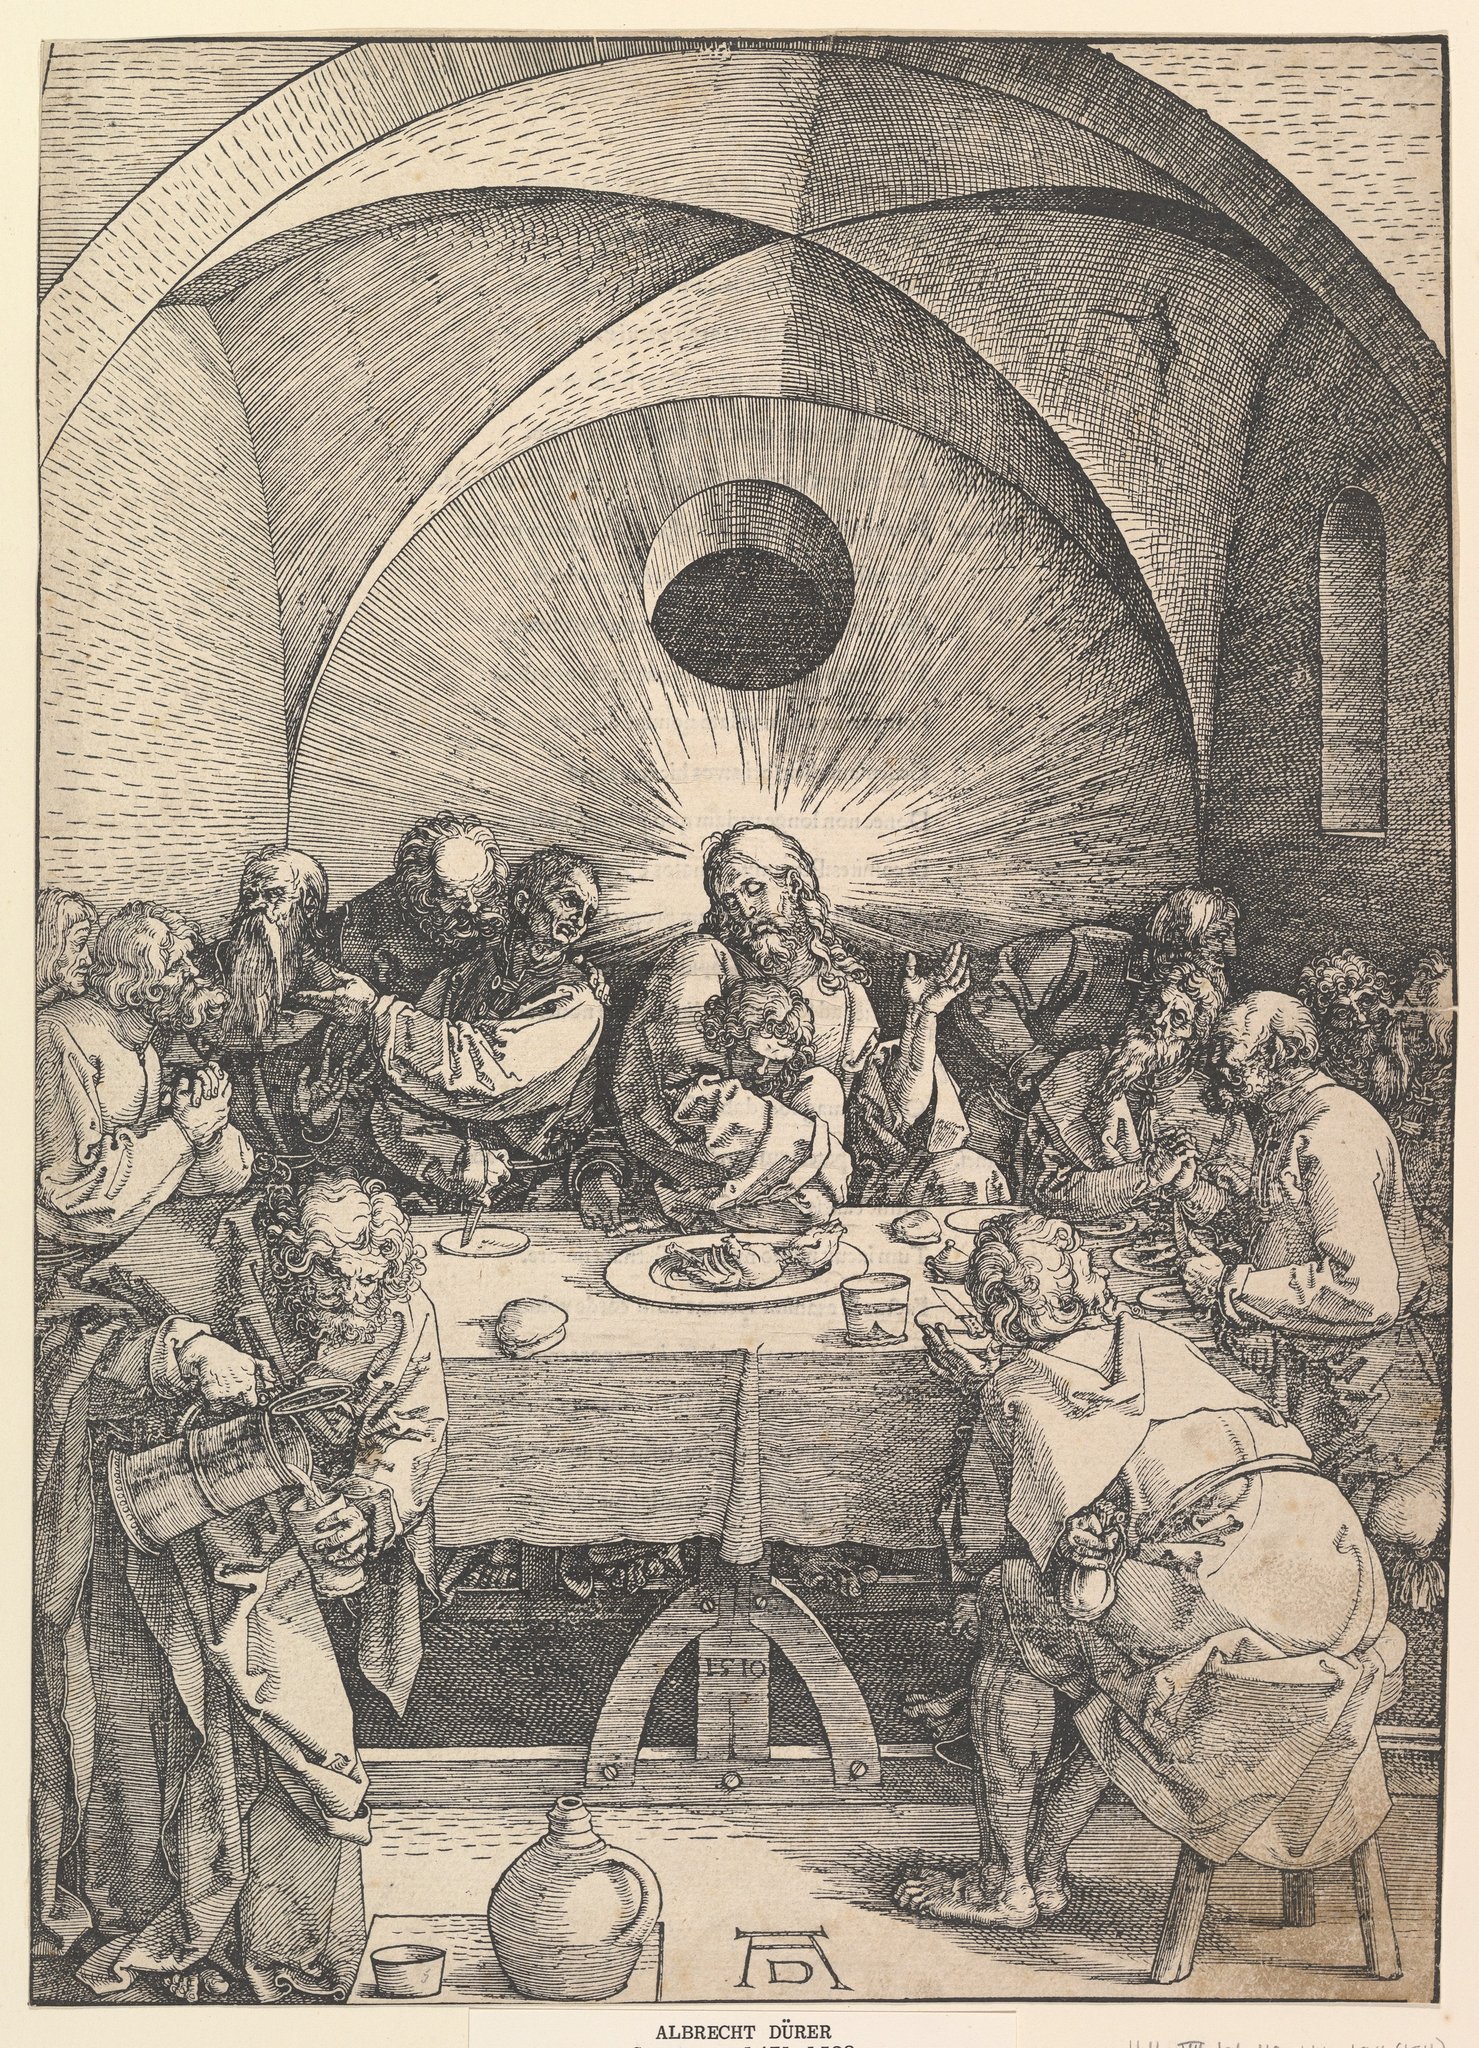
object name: print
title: The Last Supper, from "The Large Passion"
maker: albrecht dürer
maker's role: artist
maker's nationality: german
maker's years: 1471-1528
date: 1510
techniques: woodcut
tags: food,interiors,men,christ,last supper,dining,vessels